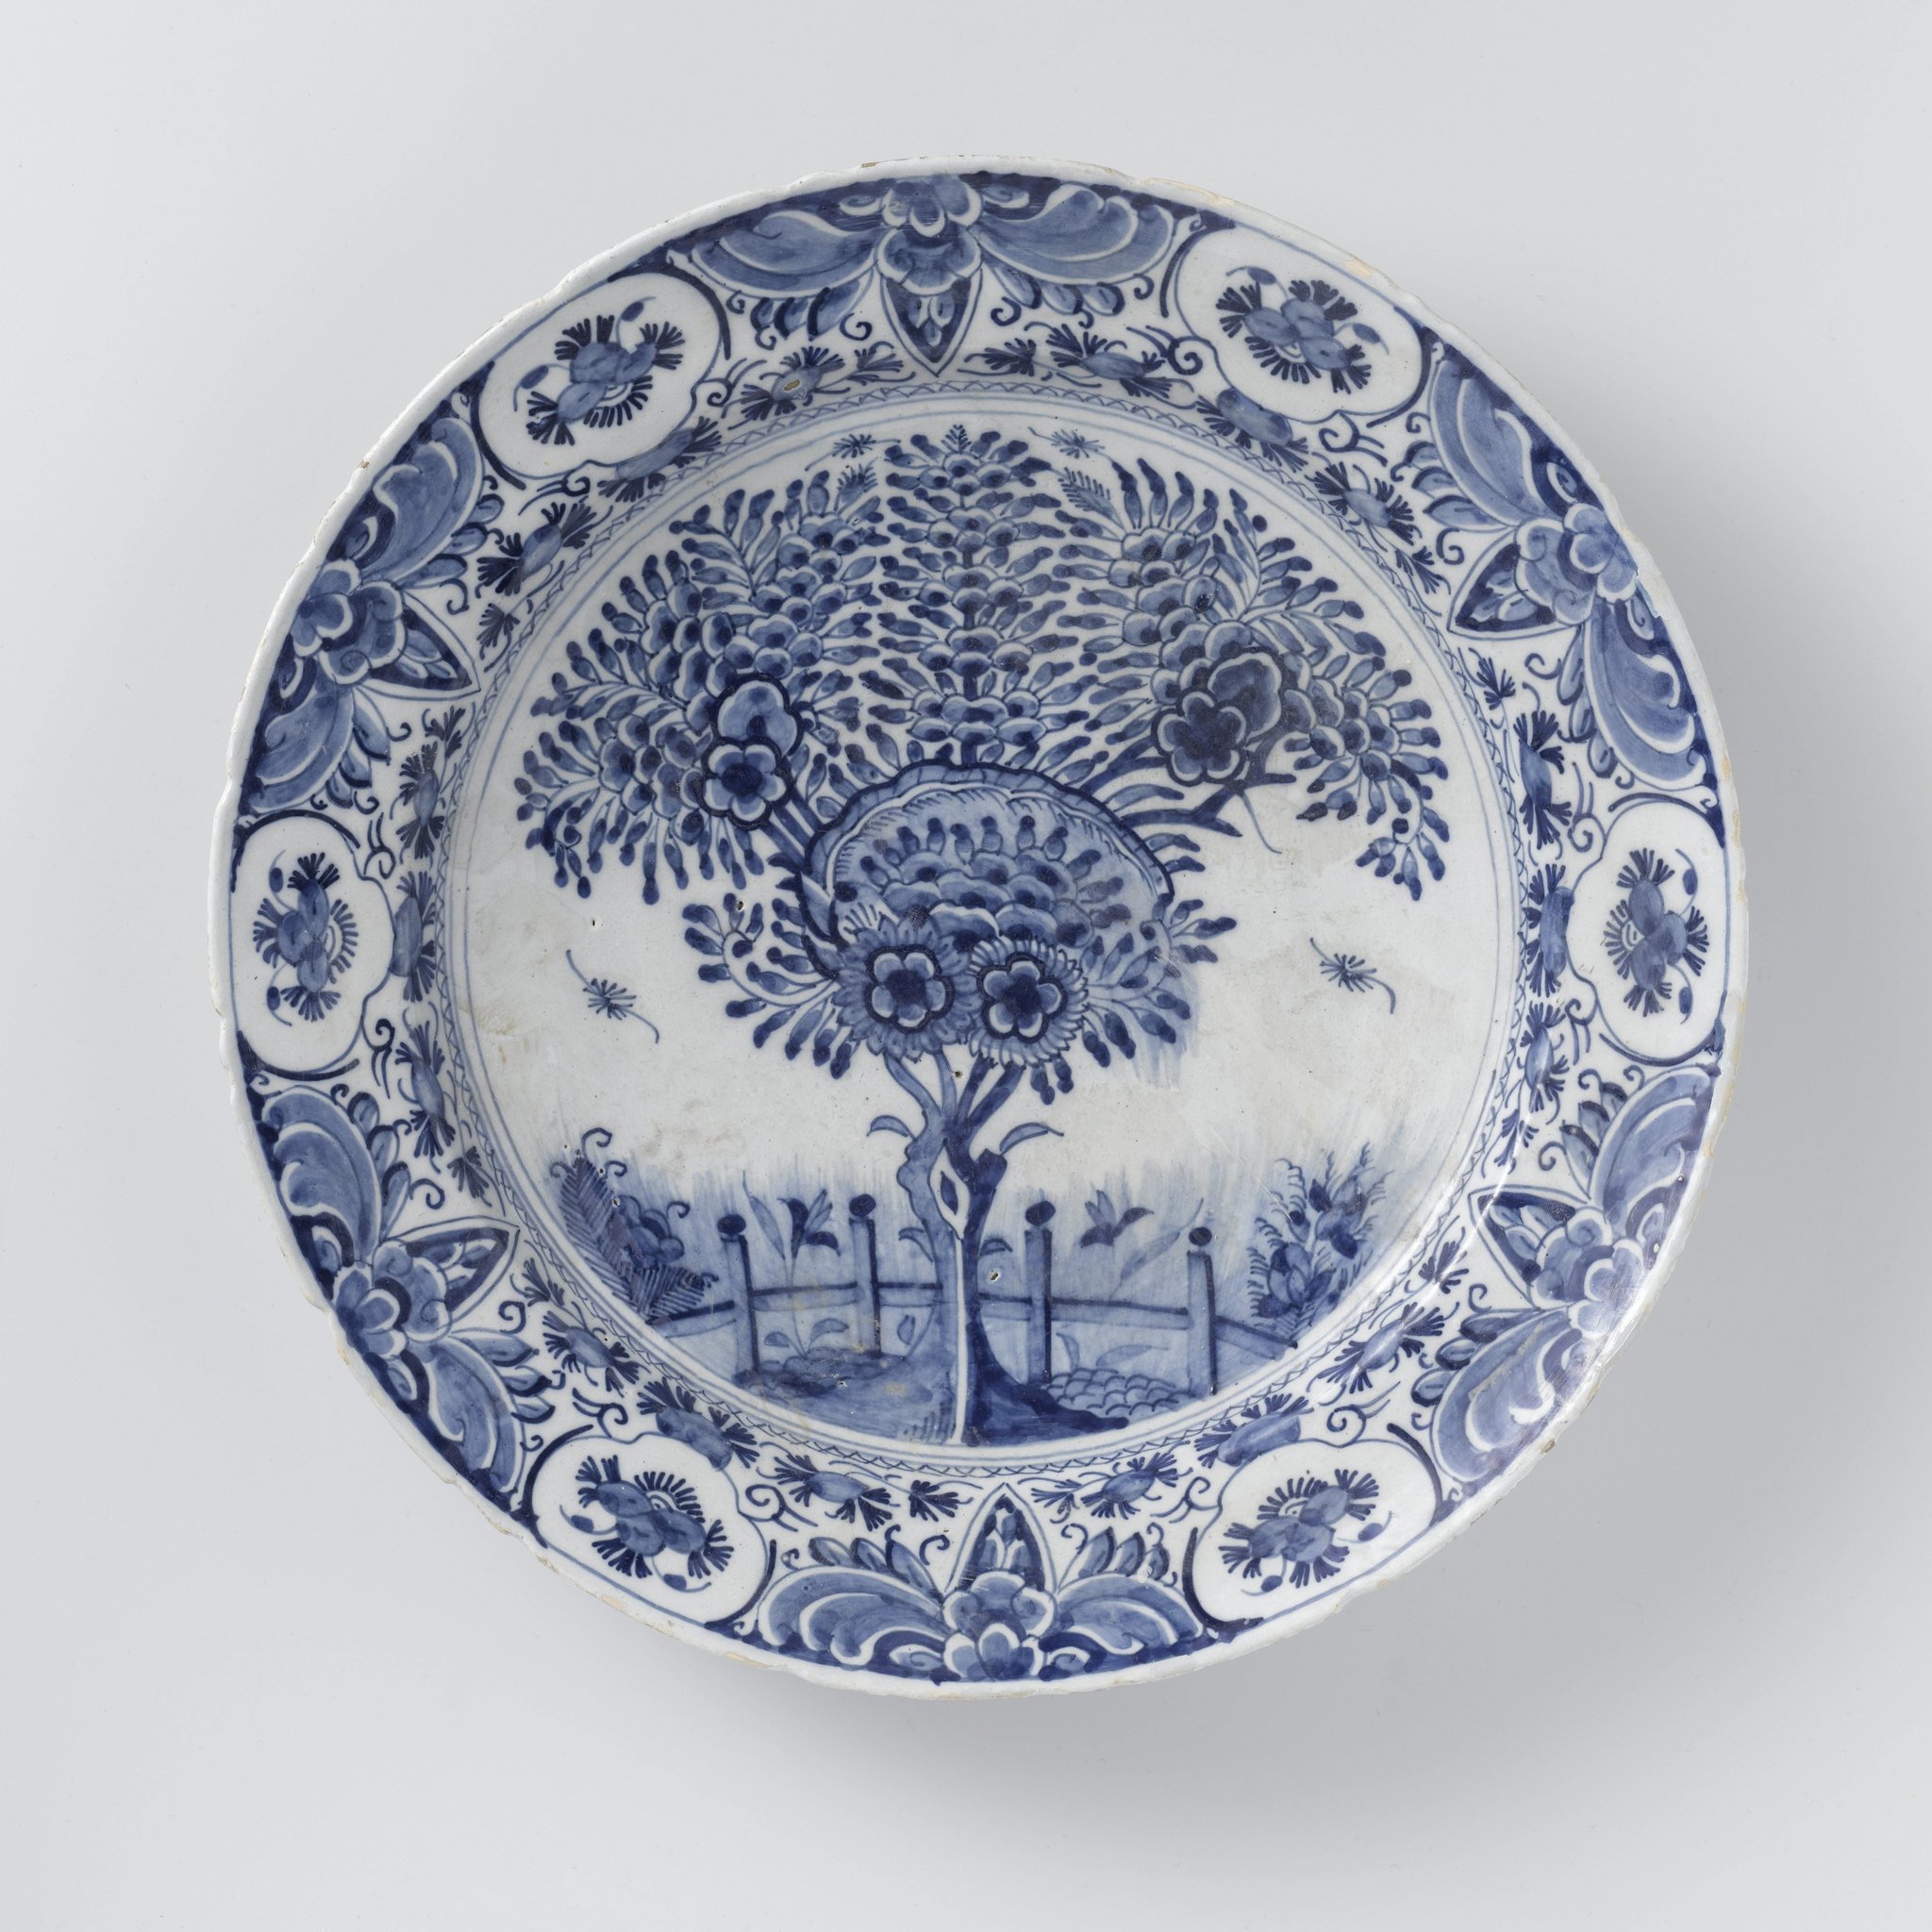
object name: platter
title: Schotel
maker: jacobus adriaens halder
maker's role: fayencier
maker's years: 1741-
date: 1764-1768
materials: earthenware, glaze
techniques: painted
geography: delft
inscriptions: mark: ‘A/ JH/ 44’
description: Ronde schotel van blauw beschilderde faience. Op het plat is een boom (theeboom ?) voor een hek geschilderd en op de rand bloemmotieven. De schotel is gemerkt met het merk van de plateelbakkerij De Grieksche A. Bij de schotel horen vier identieke schotels met invnrs. BK-NM-13291-a, BK-NM-13291-b, BK-NM-13291-c en BK-NM-13291-e.